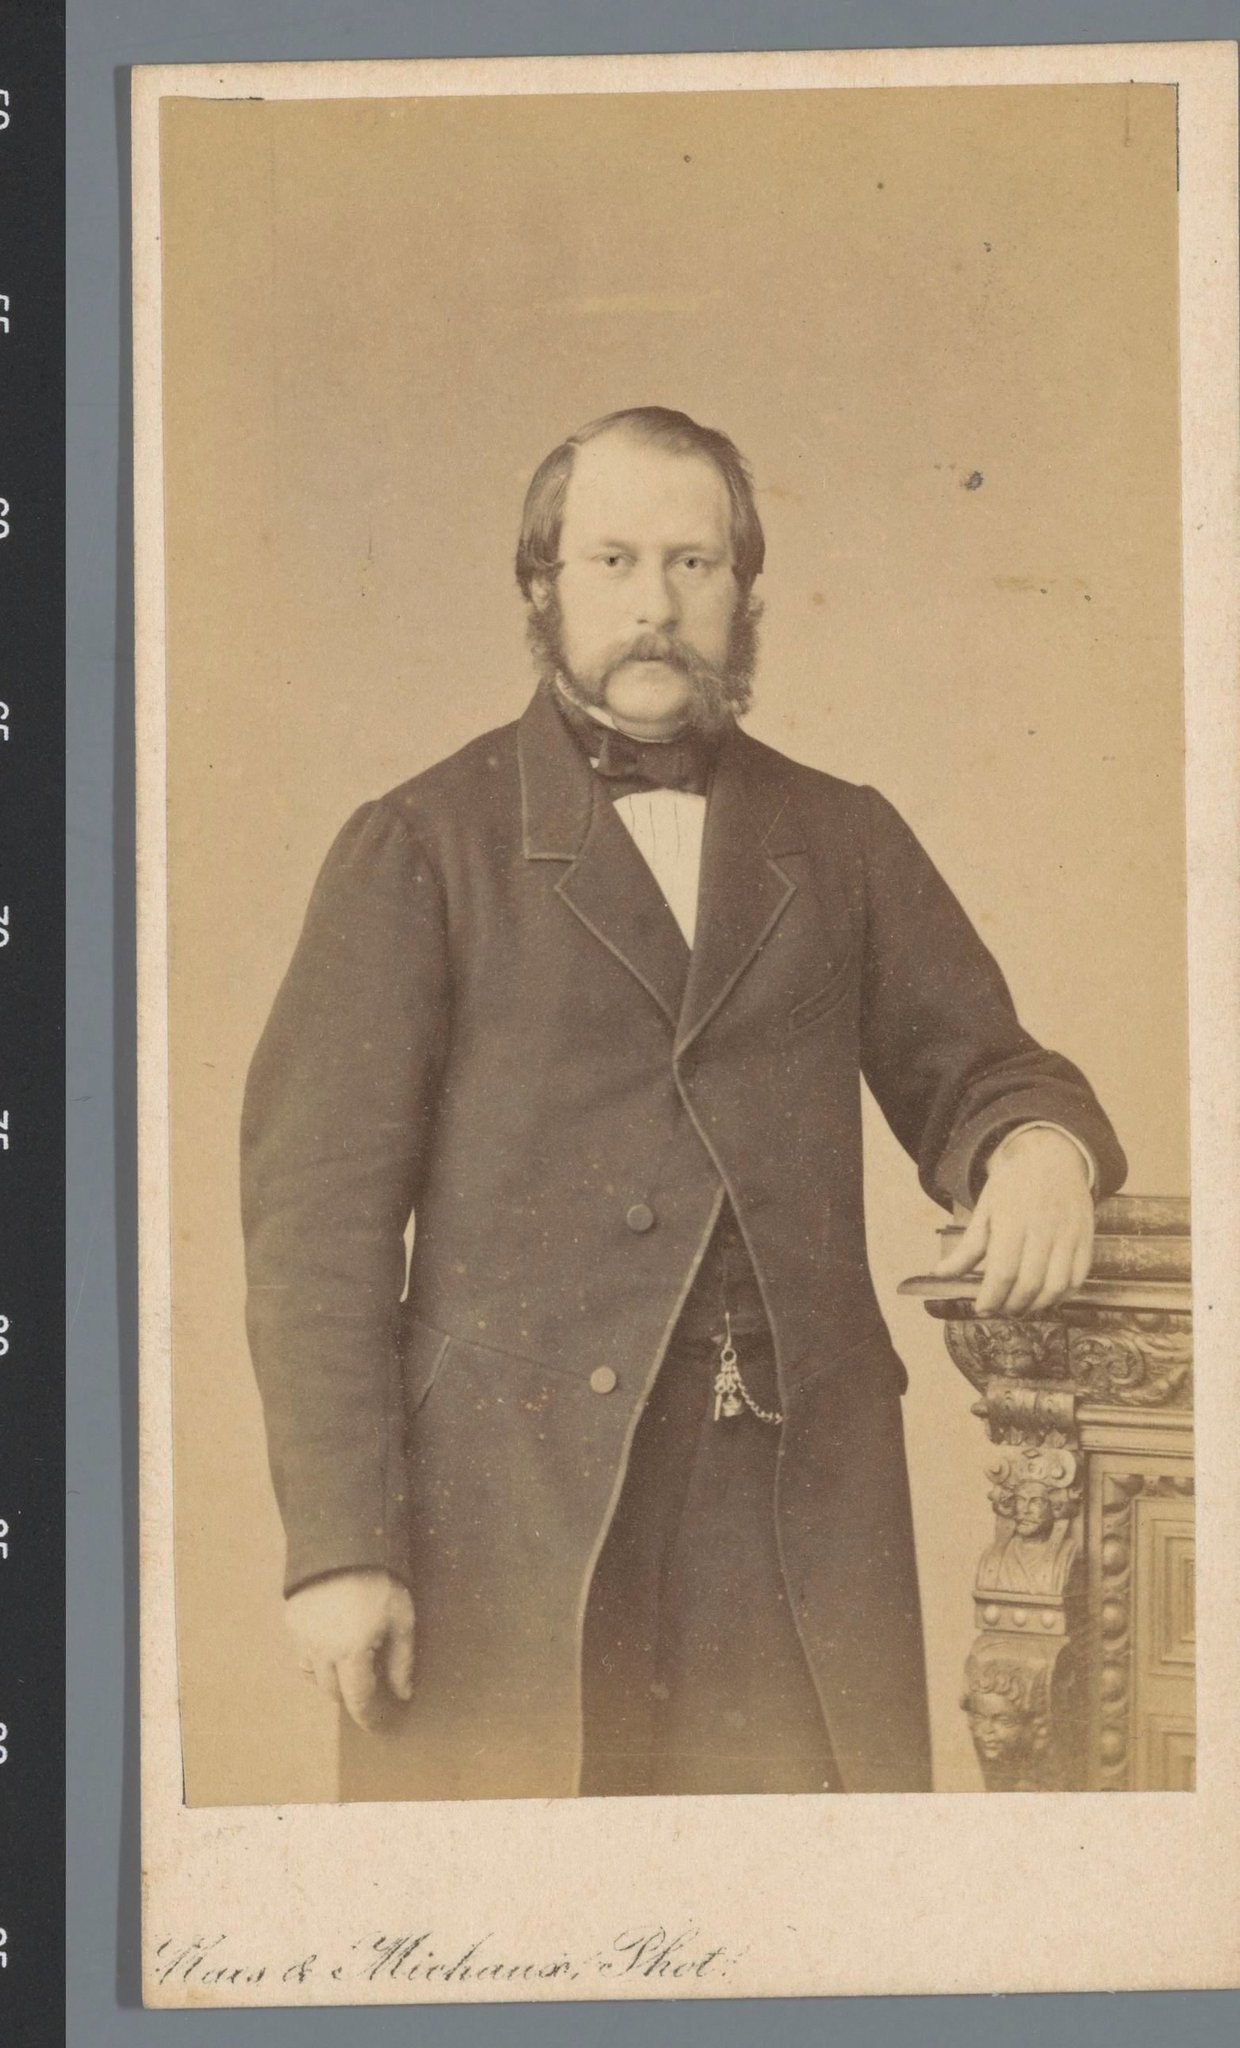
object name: carte de visite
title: Portret van een onbekende man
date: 1862-1863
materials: cardboard, paper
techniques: albumen print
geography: brussels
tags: adult man, anonymous historical person portrayed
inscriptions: inscription: ‘EXPOSITION 1861.’, address: ‘Place de la Monnaie,/ BRUXELLES./ Rue Fossés aux Loups, 36.’